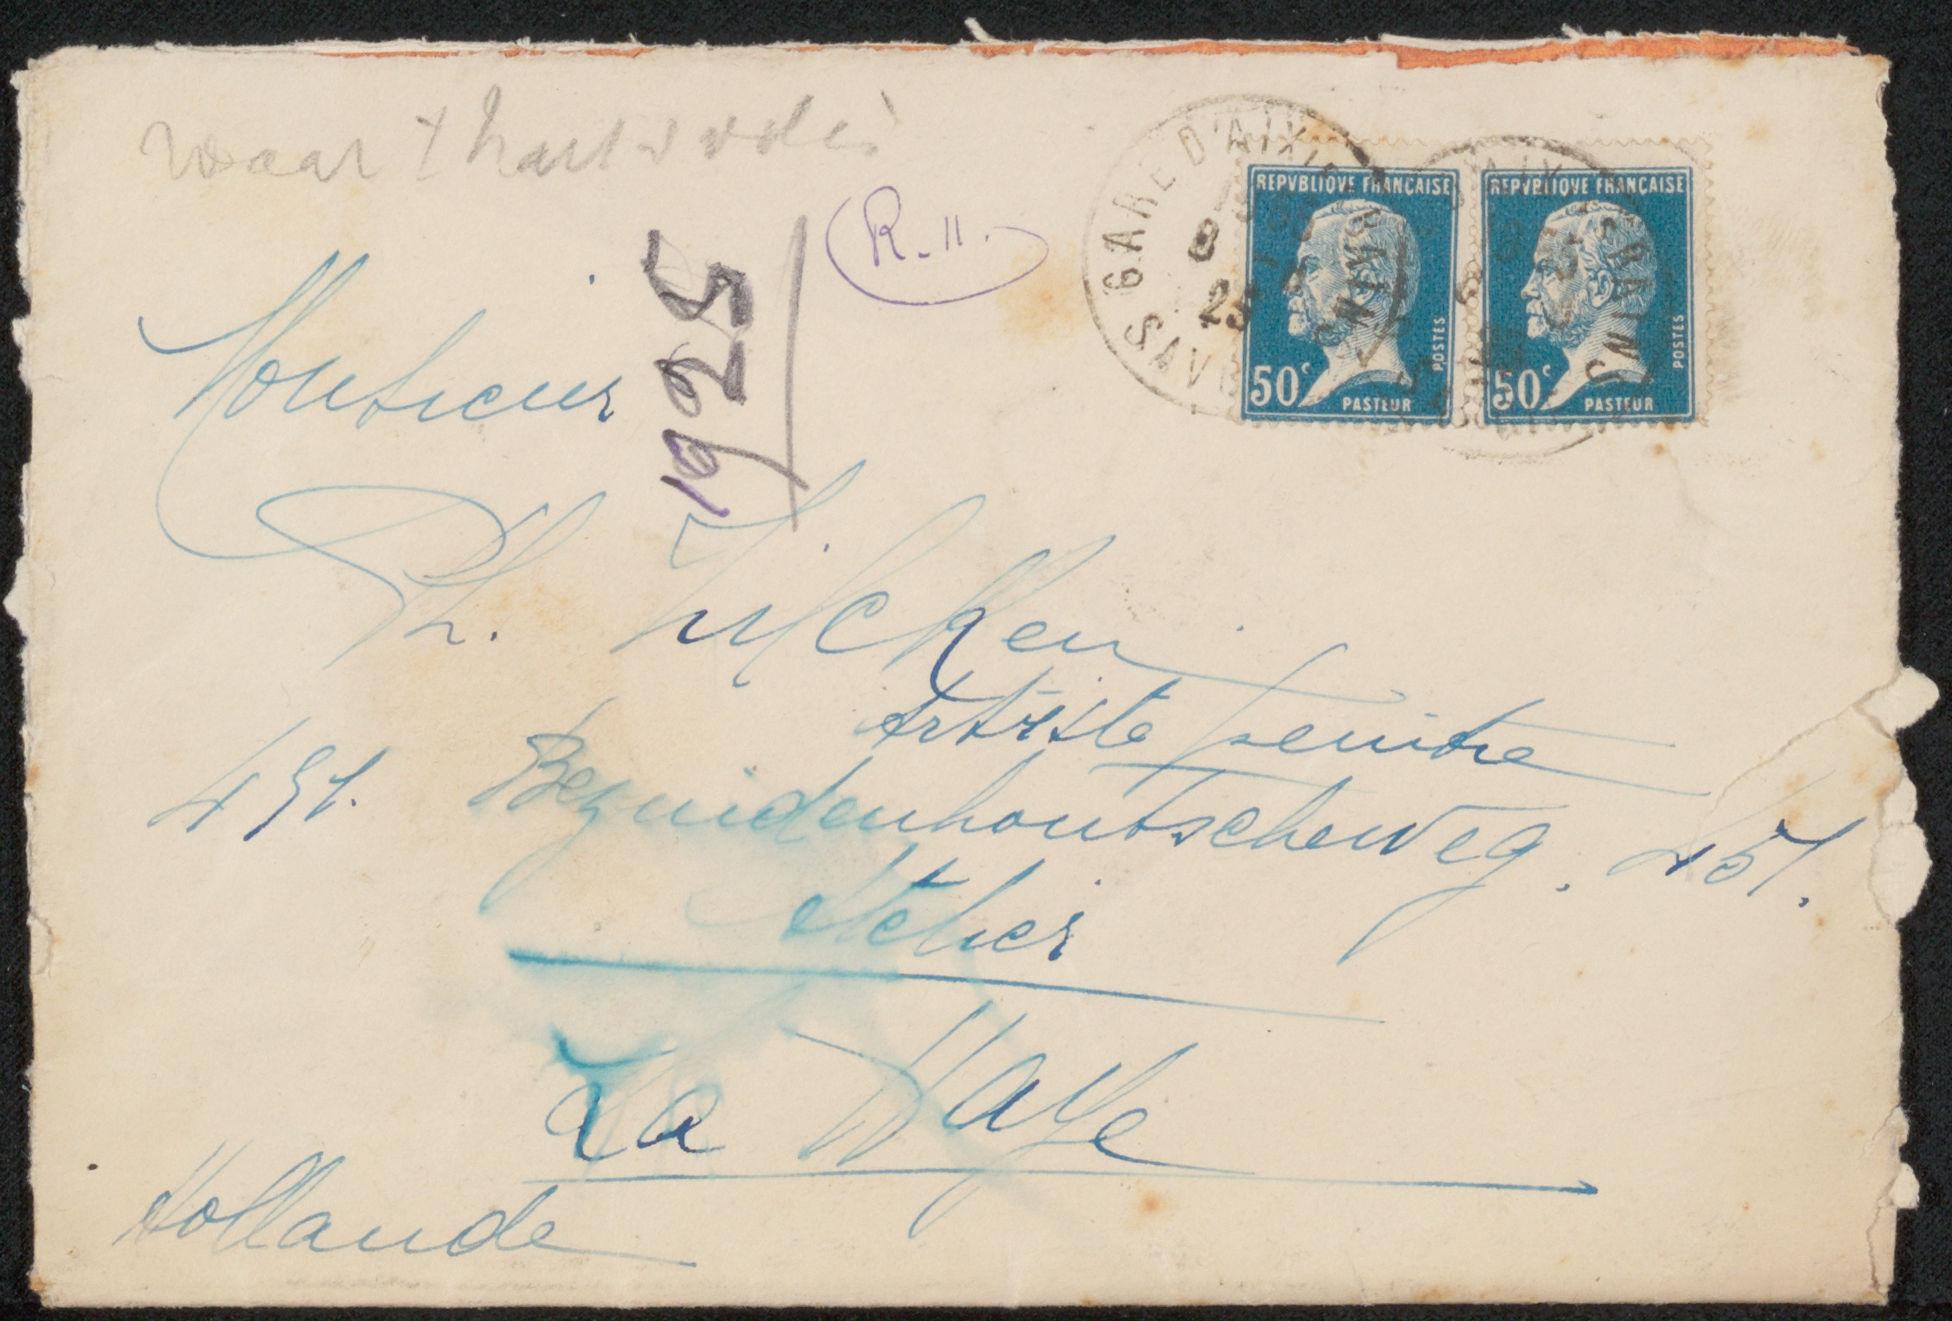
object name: envelope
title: Envelop aan Philip Zilcken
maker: rose imel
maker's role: draughtsman, painter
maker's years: 1901-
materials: ink, paper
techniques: pen, writing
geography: aix-les-bains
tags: the hague, painter, draughtsman, philip zilcken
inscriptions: collector's mark: ‘RPK’